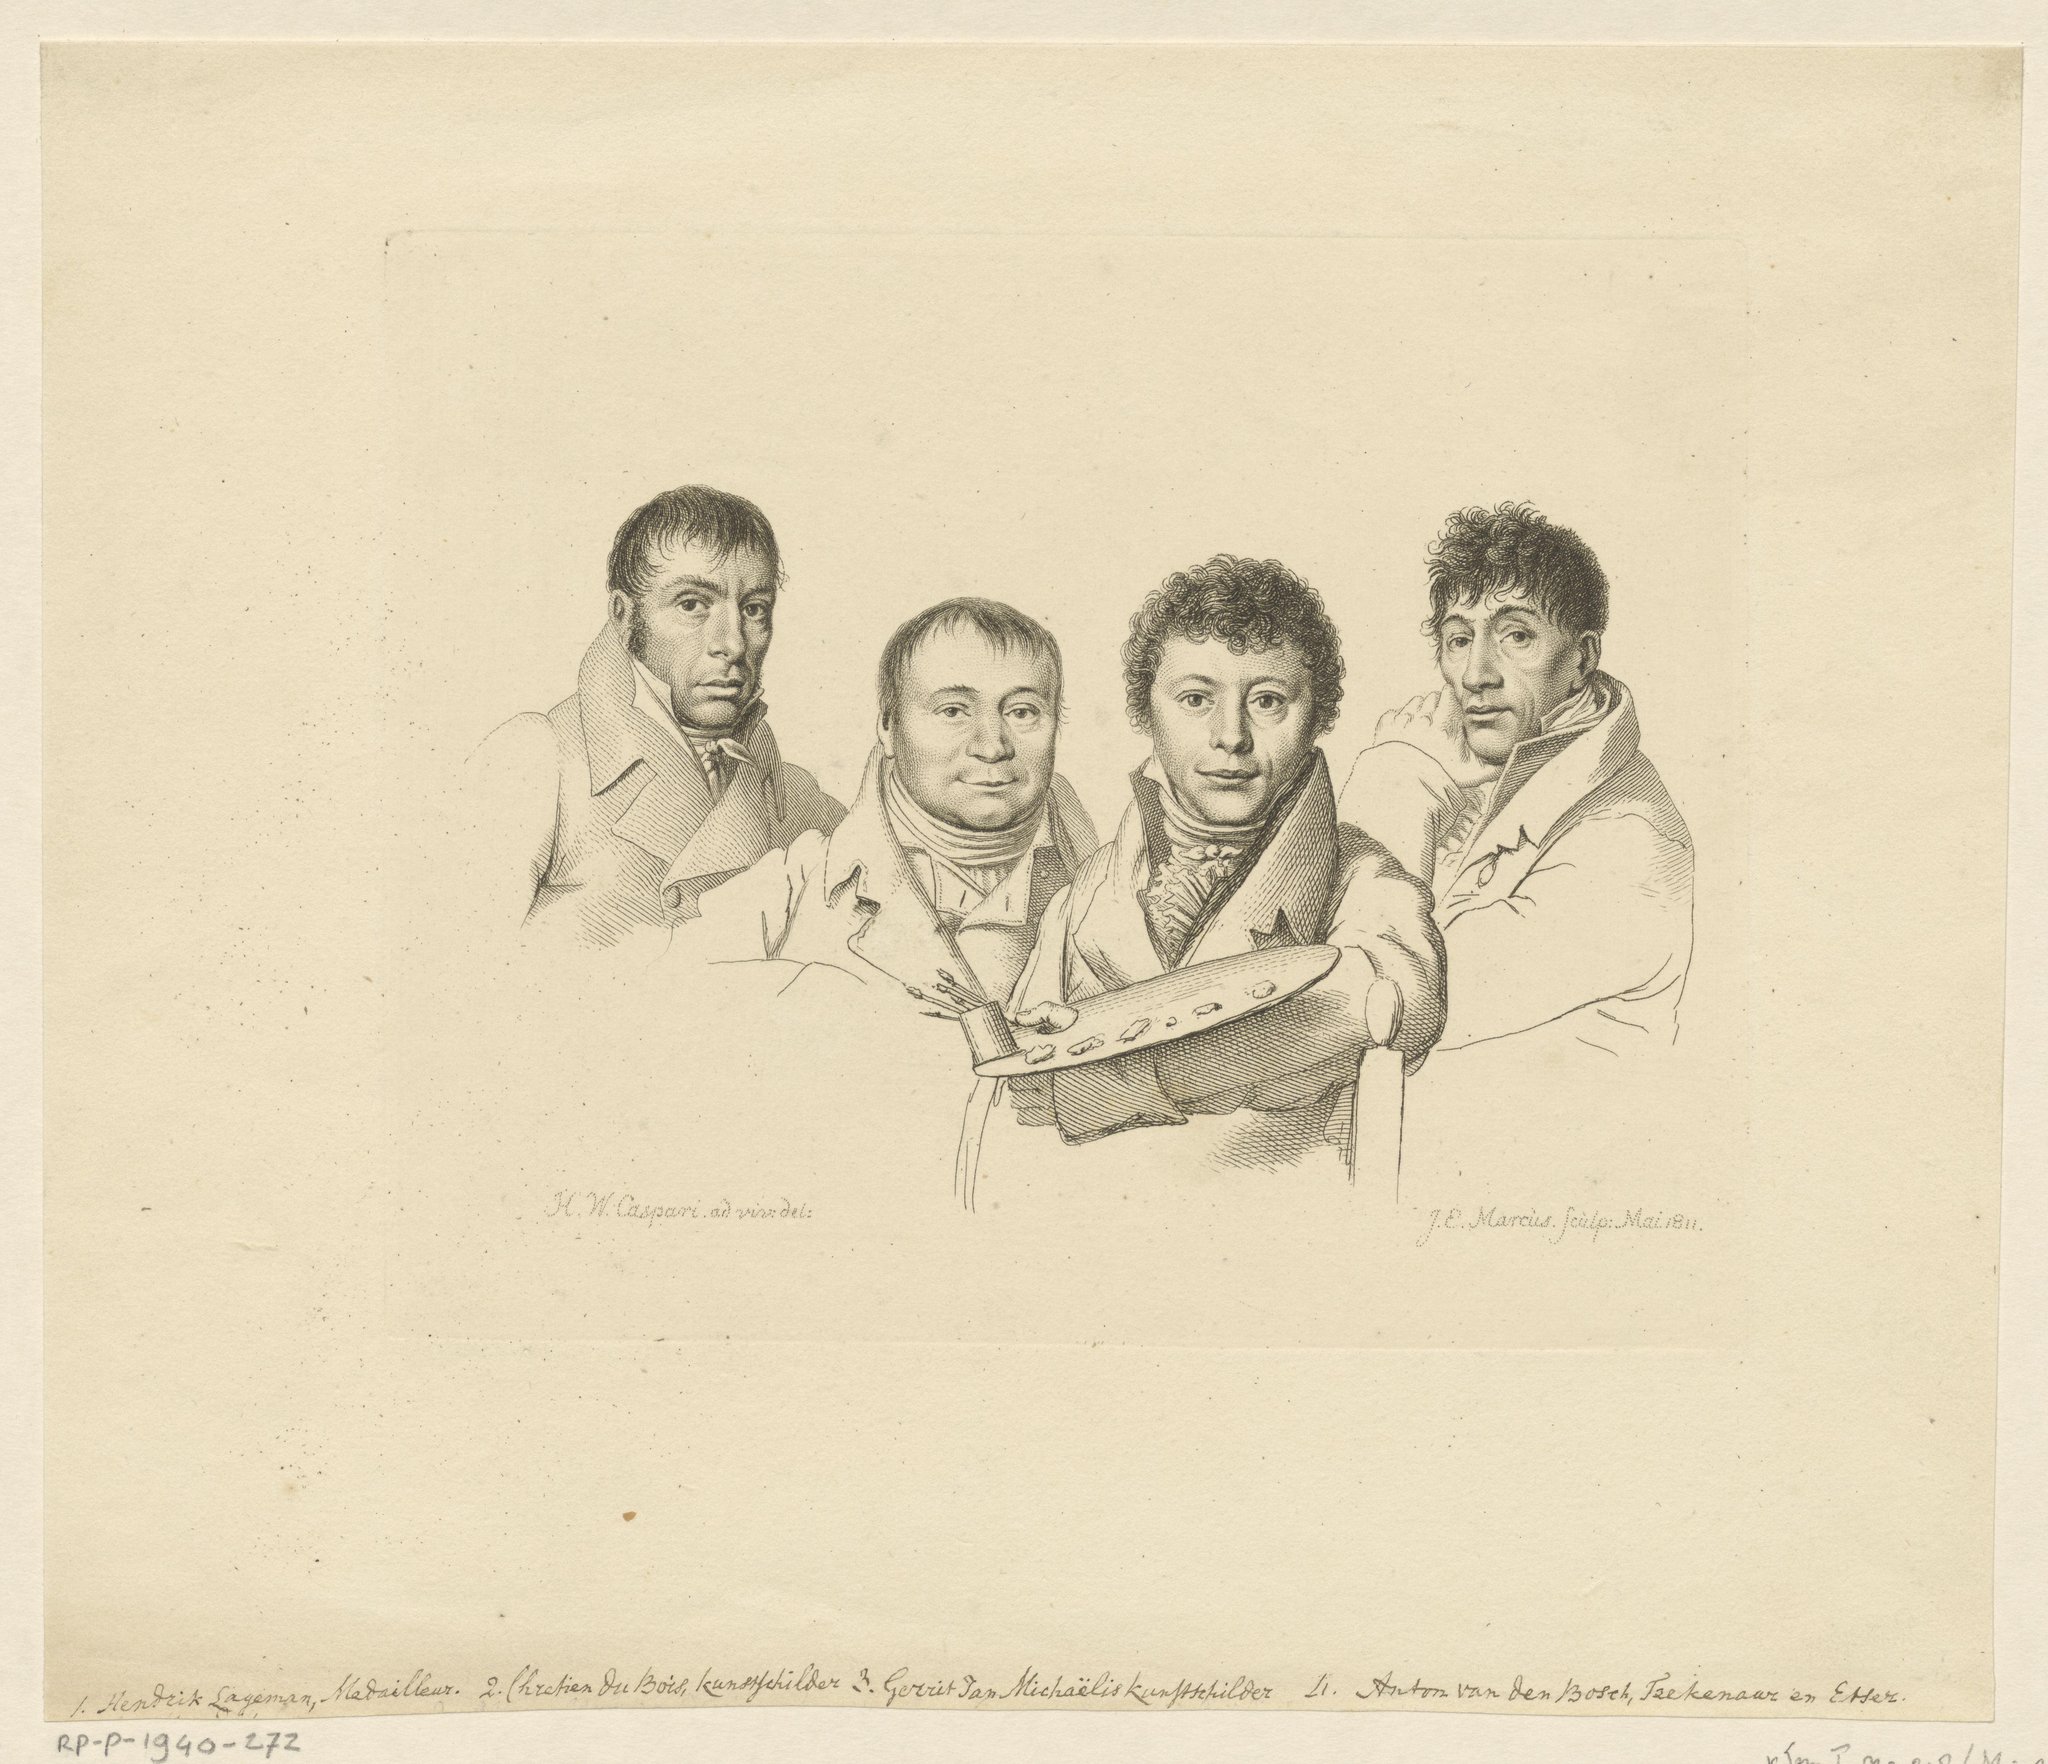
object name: print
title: Studiewerk van Jacob Ernst Marcus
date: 1811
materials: paper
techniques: engraving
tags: nijmegen, amsterdam, print maker, draughtsman, anthonie van den bos, chrétien dubois, haarlem, gerrit jan michaëlis, hendrik lageman, historical persons, portrait, self-portrait of painter, portrait, self-portrait of artist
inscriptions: collector's mark: Lugt 2228, collector's mark: Lugt 2760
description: Geportretteerden van links naar rechts. Gerrit Jan Michaelis heeft een schilderspalet in zijn linkerhand.